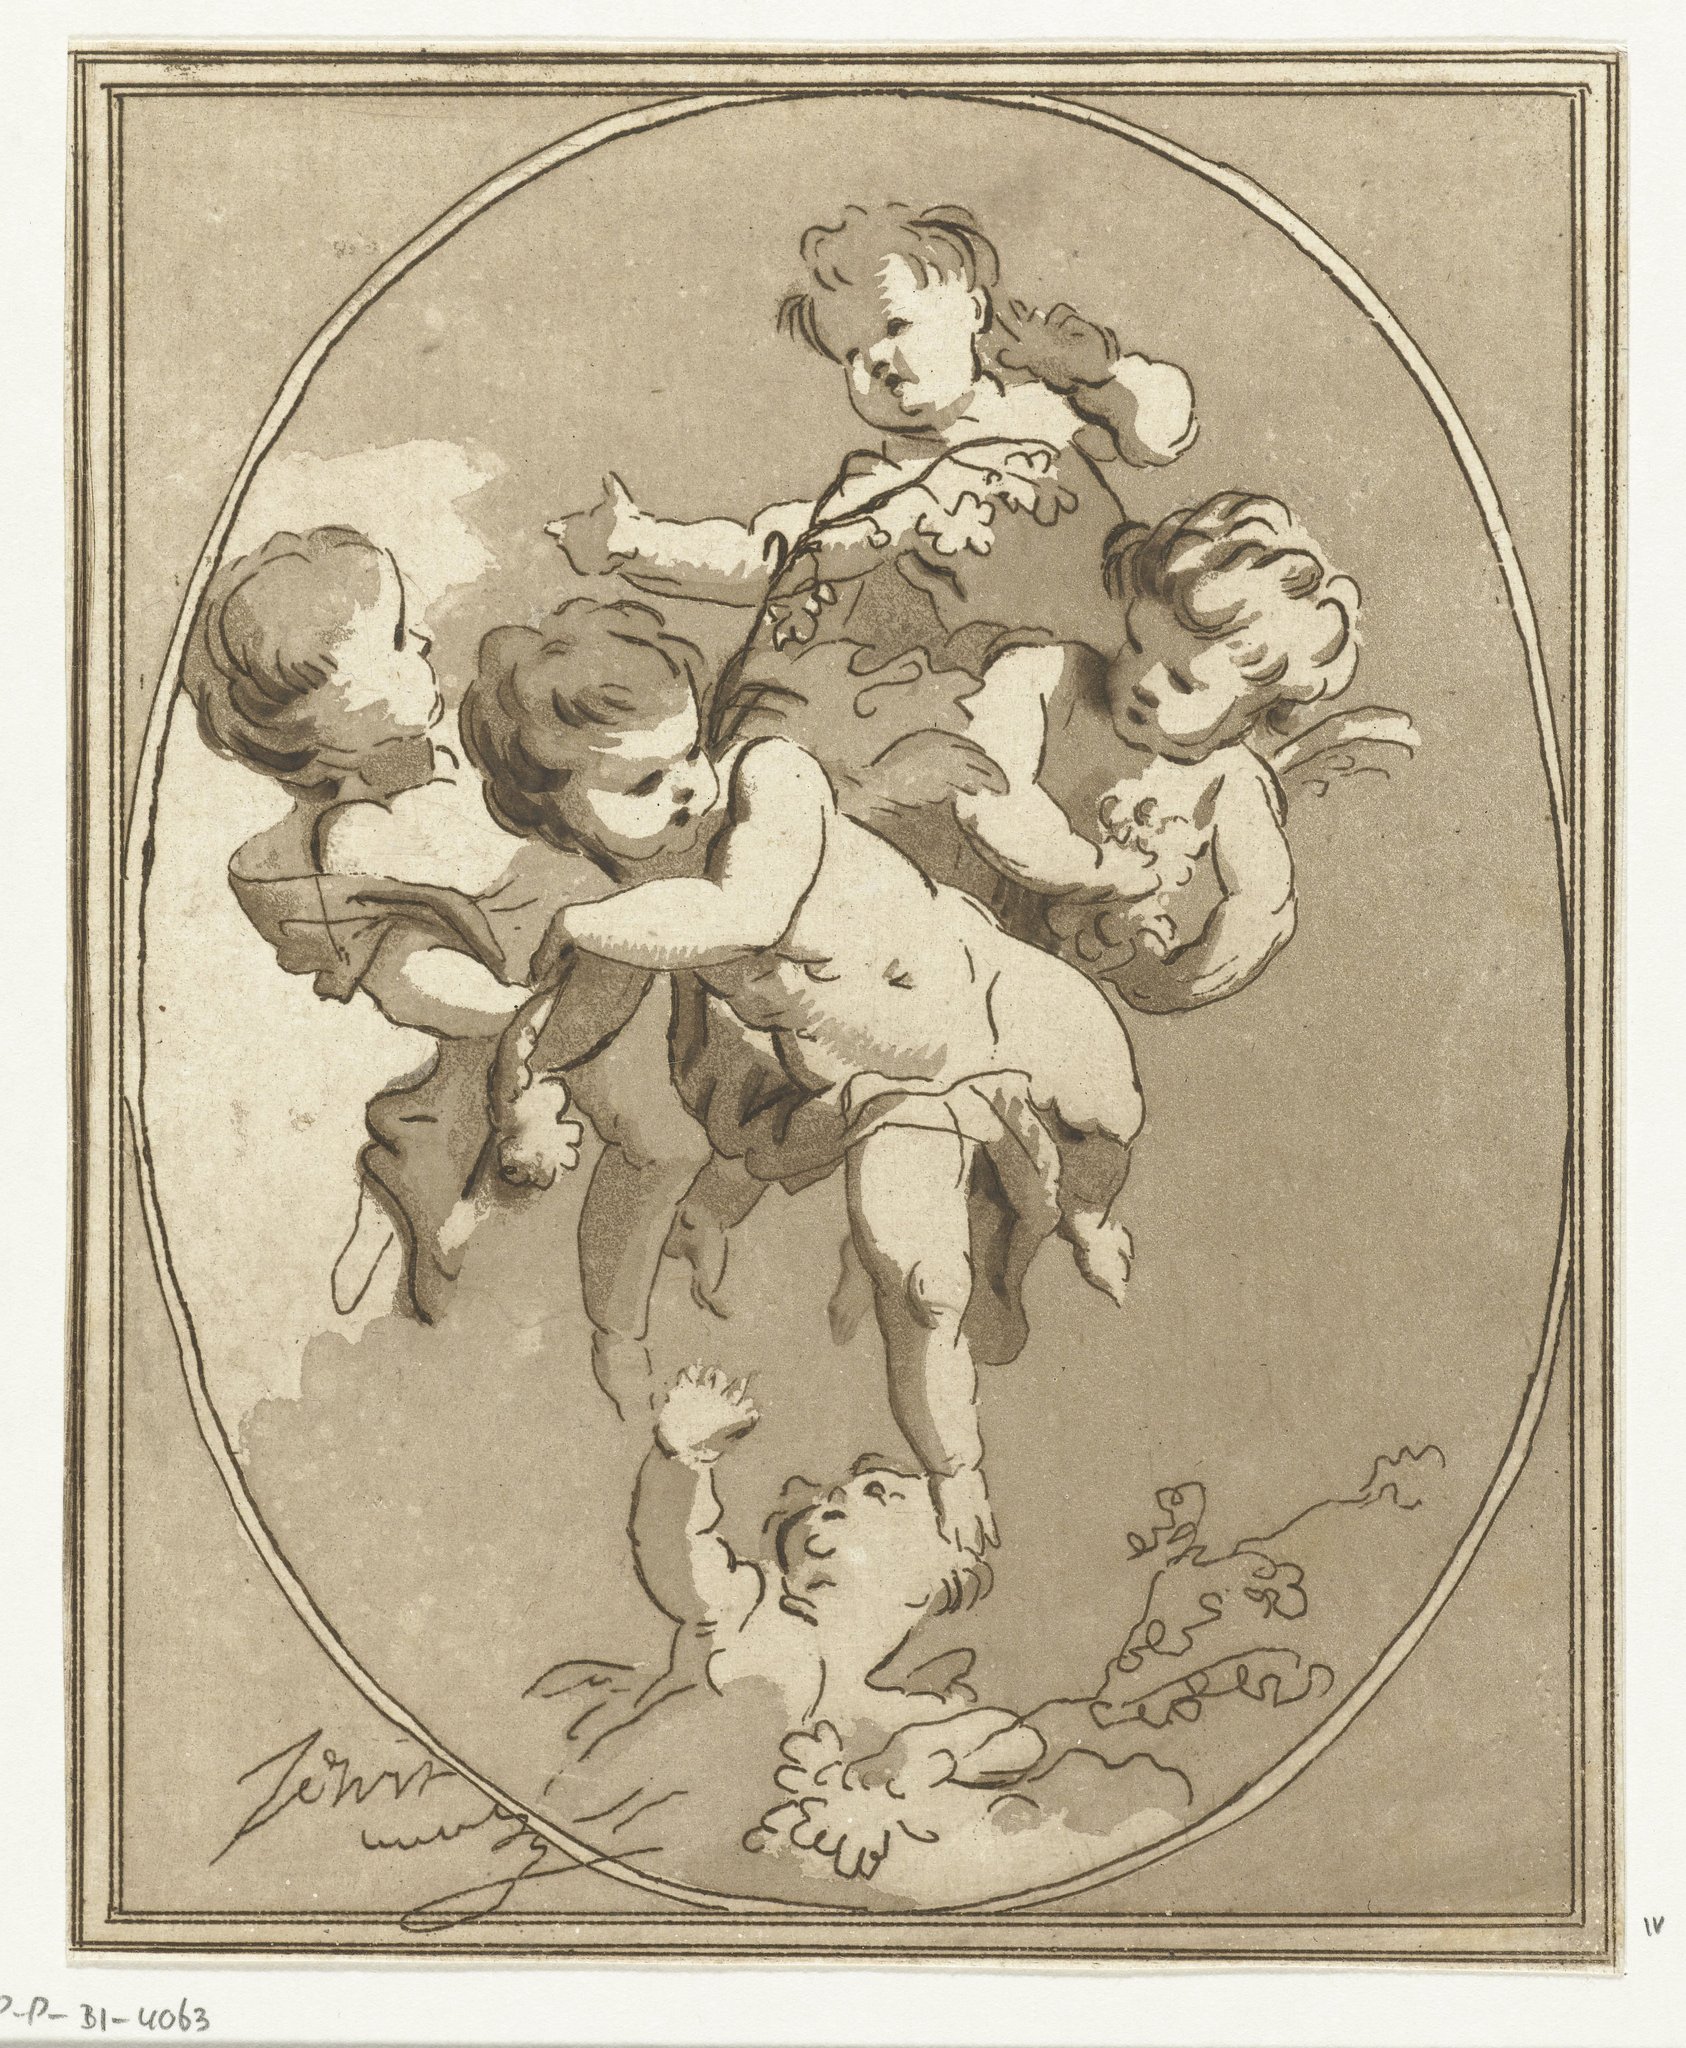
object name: print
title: Vijf putti met bloemtakken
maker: anthonie van den bos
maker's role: draughtsman, print maker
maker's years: 1763-1838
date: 1778-1838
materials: paper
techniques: aquatint, etching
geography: netherlands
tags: cupids: 'amores', 'amoretti', 'putti'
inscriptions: collector's mark: Lugt 2228